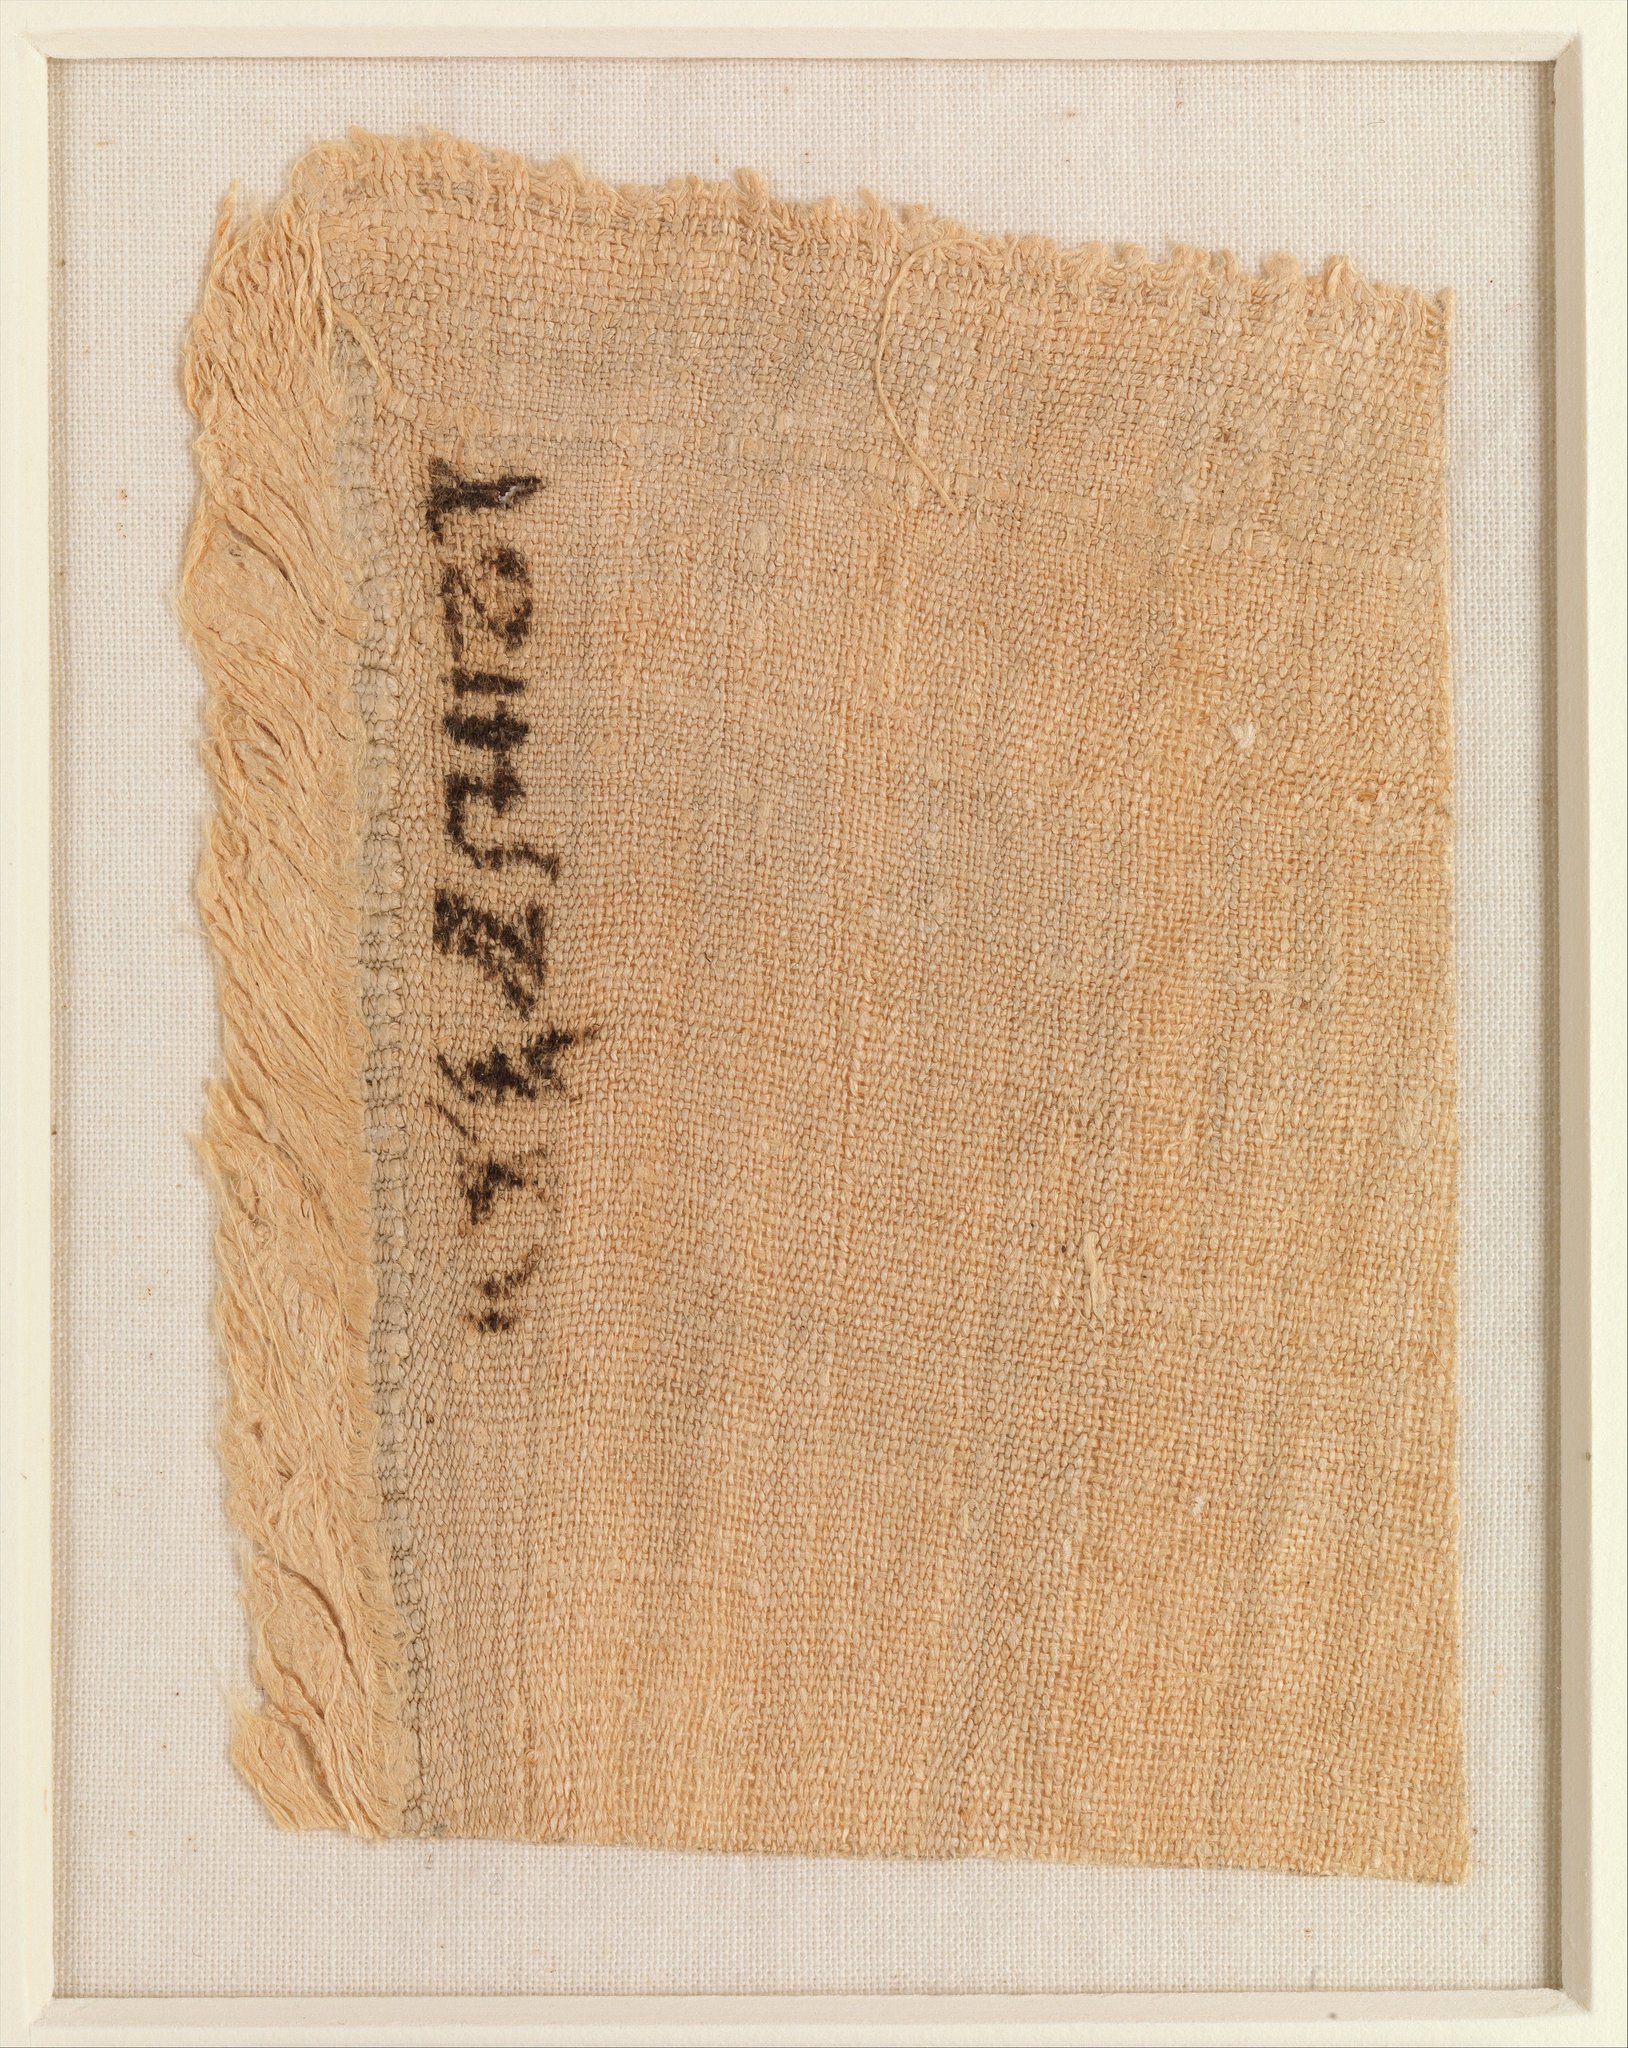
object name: linen mark, wah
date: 1981-1975 BCE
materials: linen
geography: egypt